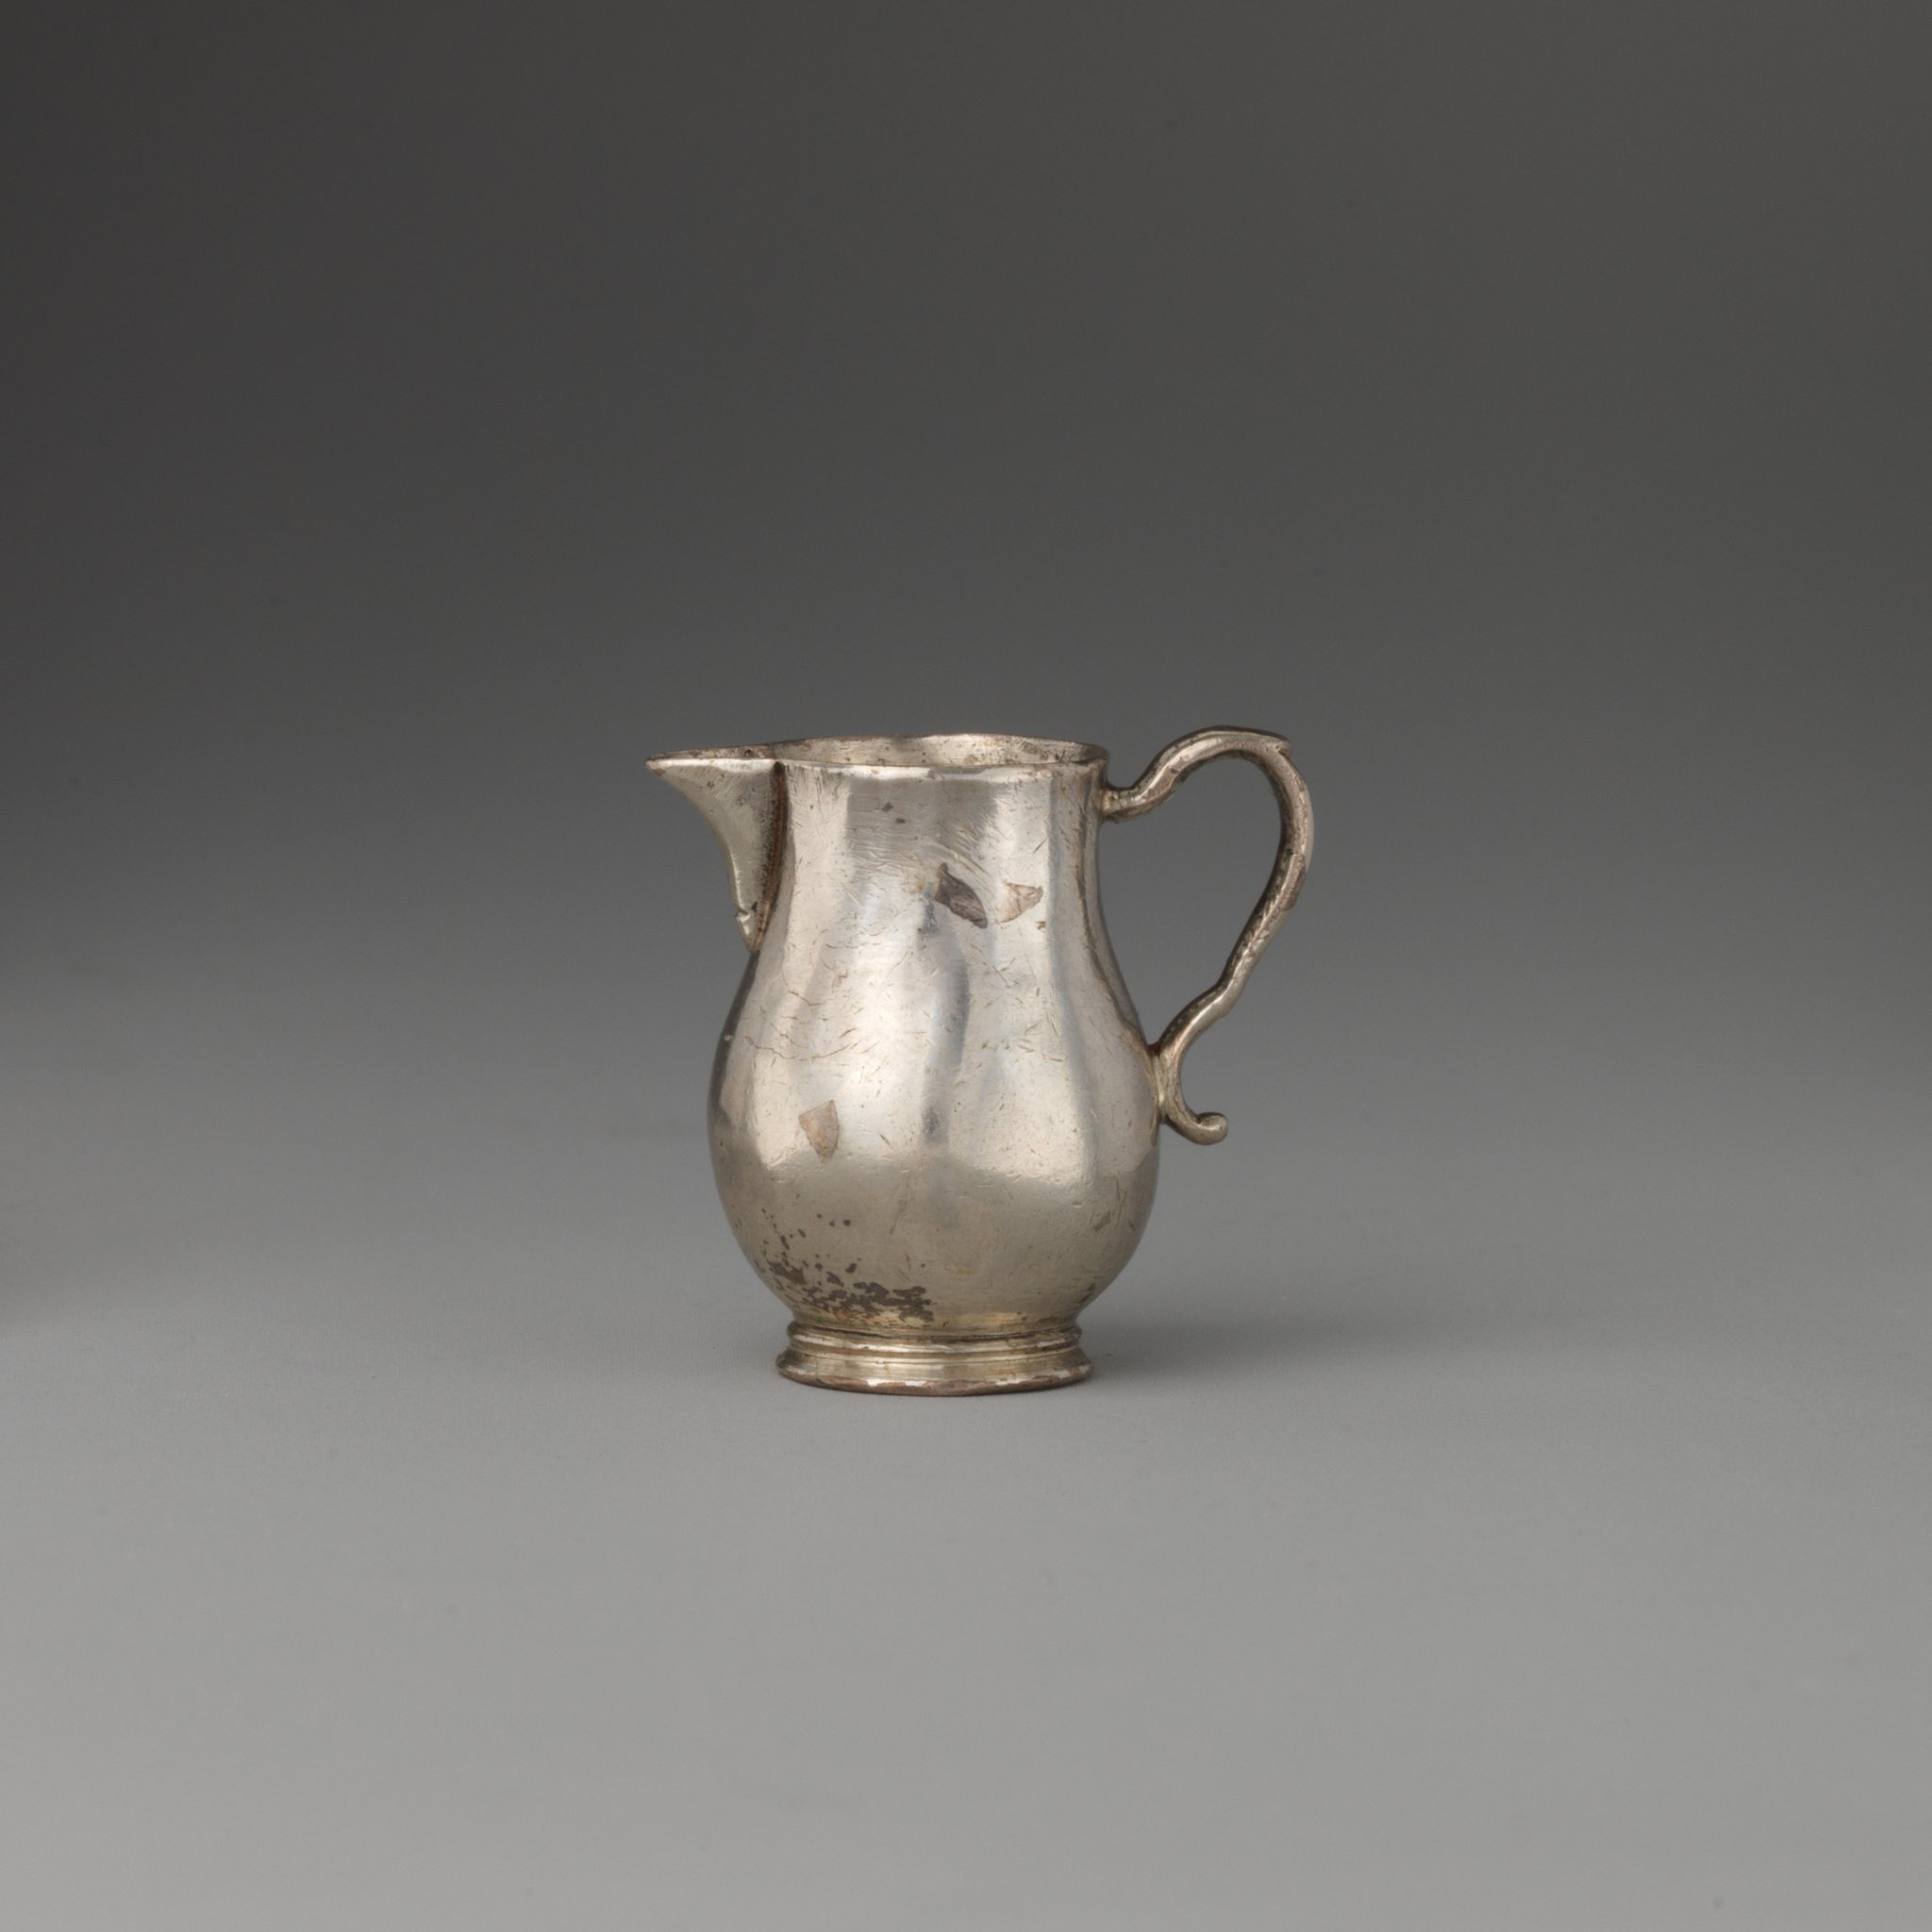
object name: cream jug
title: Miniature cream jug (part of a set)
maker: david clayton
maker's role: maker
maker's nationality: british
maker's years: 1659-1719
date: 1667-1733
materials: silver